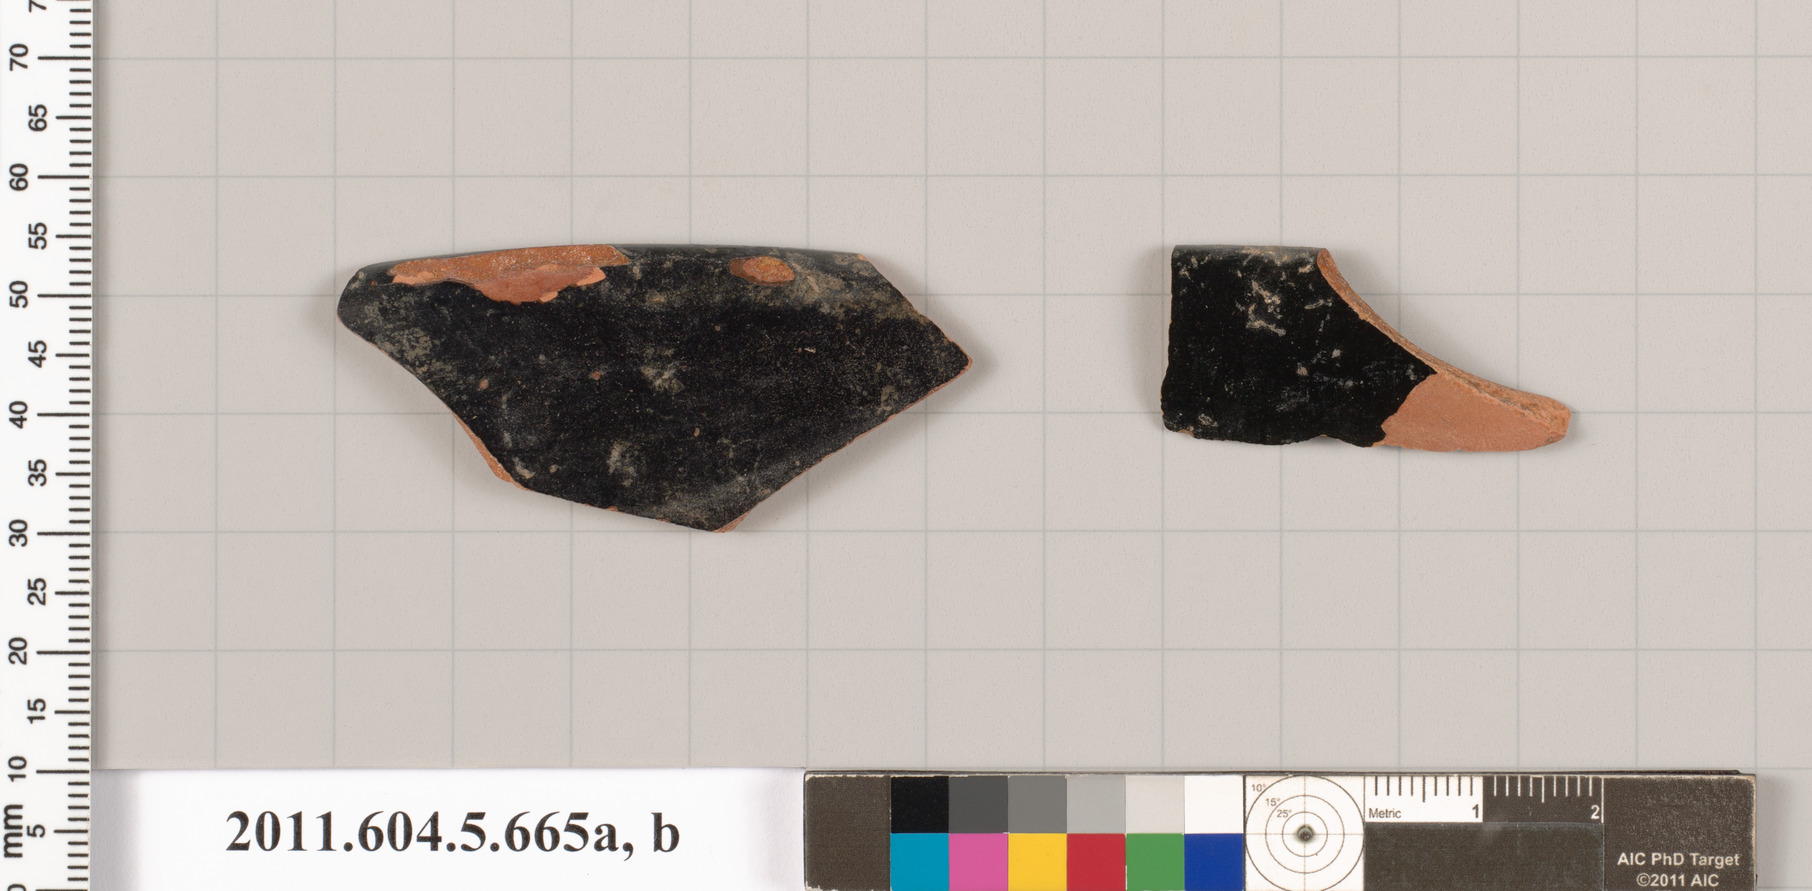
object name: kylix fragment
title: Terracotta rim fragments of kylikes (drinking cups)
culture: greek, attic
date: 600-401 BCE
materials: terracotta